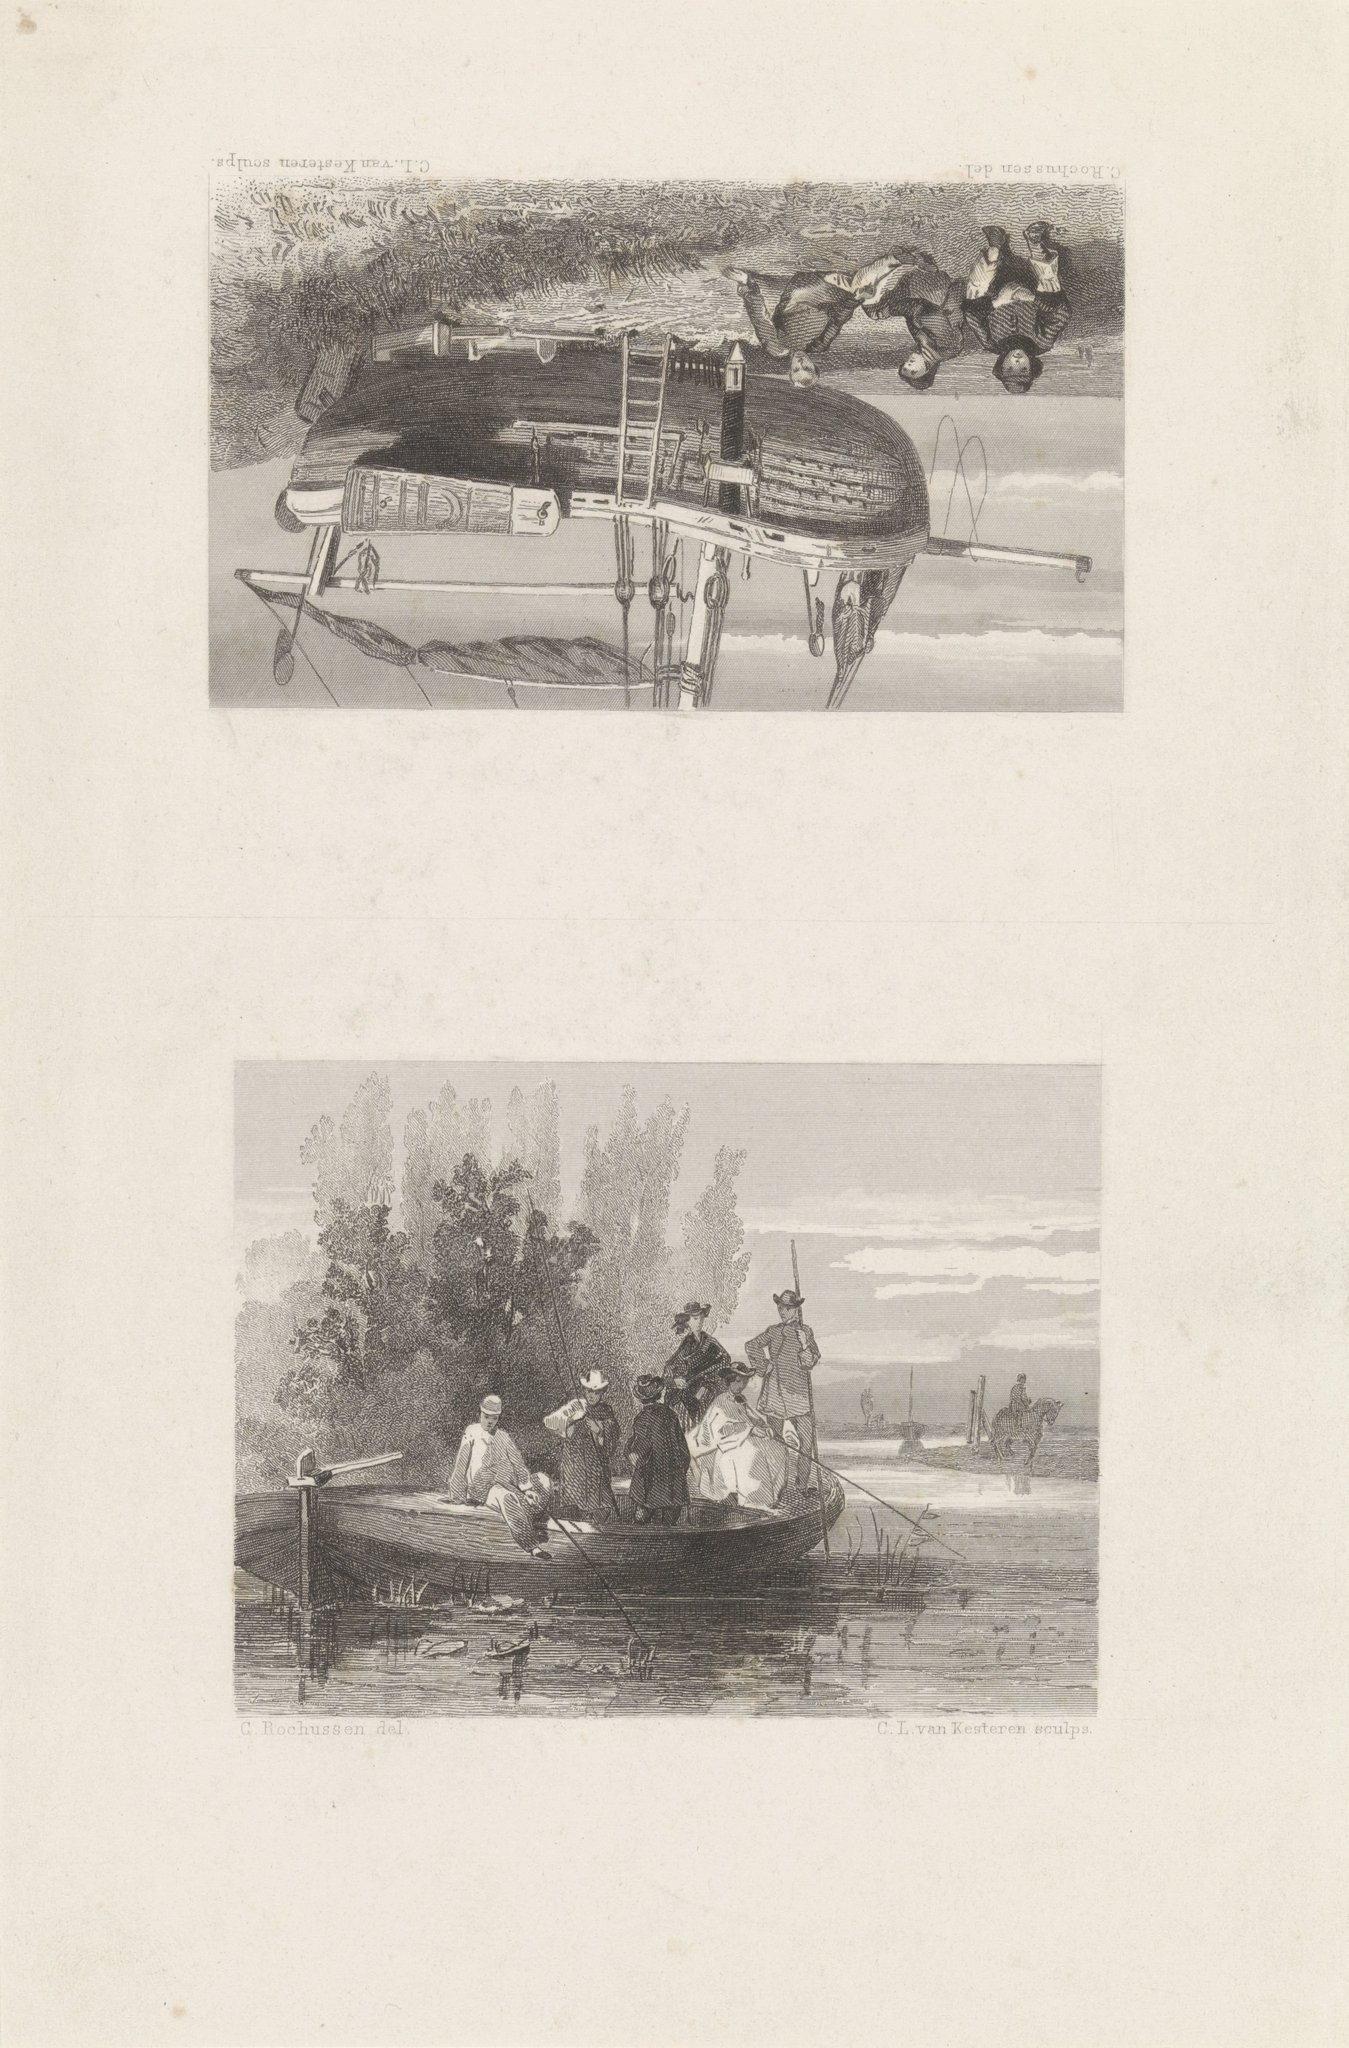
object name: print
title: Roeiboot en zeilboot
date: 1842-1897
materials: paper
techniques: engraving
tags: sailing-ship, sailing-boat, rowing-boat, canoe, etc., angling, in or beside the water (on the beach)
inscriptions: collector's mark: Lugt 2228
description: Blad met twee afbeeldingen. Boven: een zeilboot op het strand met daarvoor drie jongens. Onder: een sloep, tussen de waterlelies, met zes figuren waarvan er enkele aan het vissen zijn. Op de achtergrond een man op een paard.